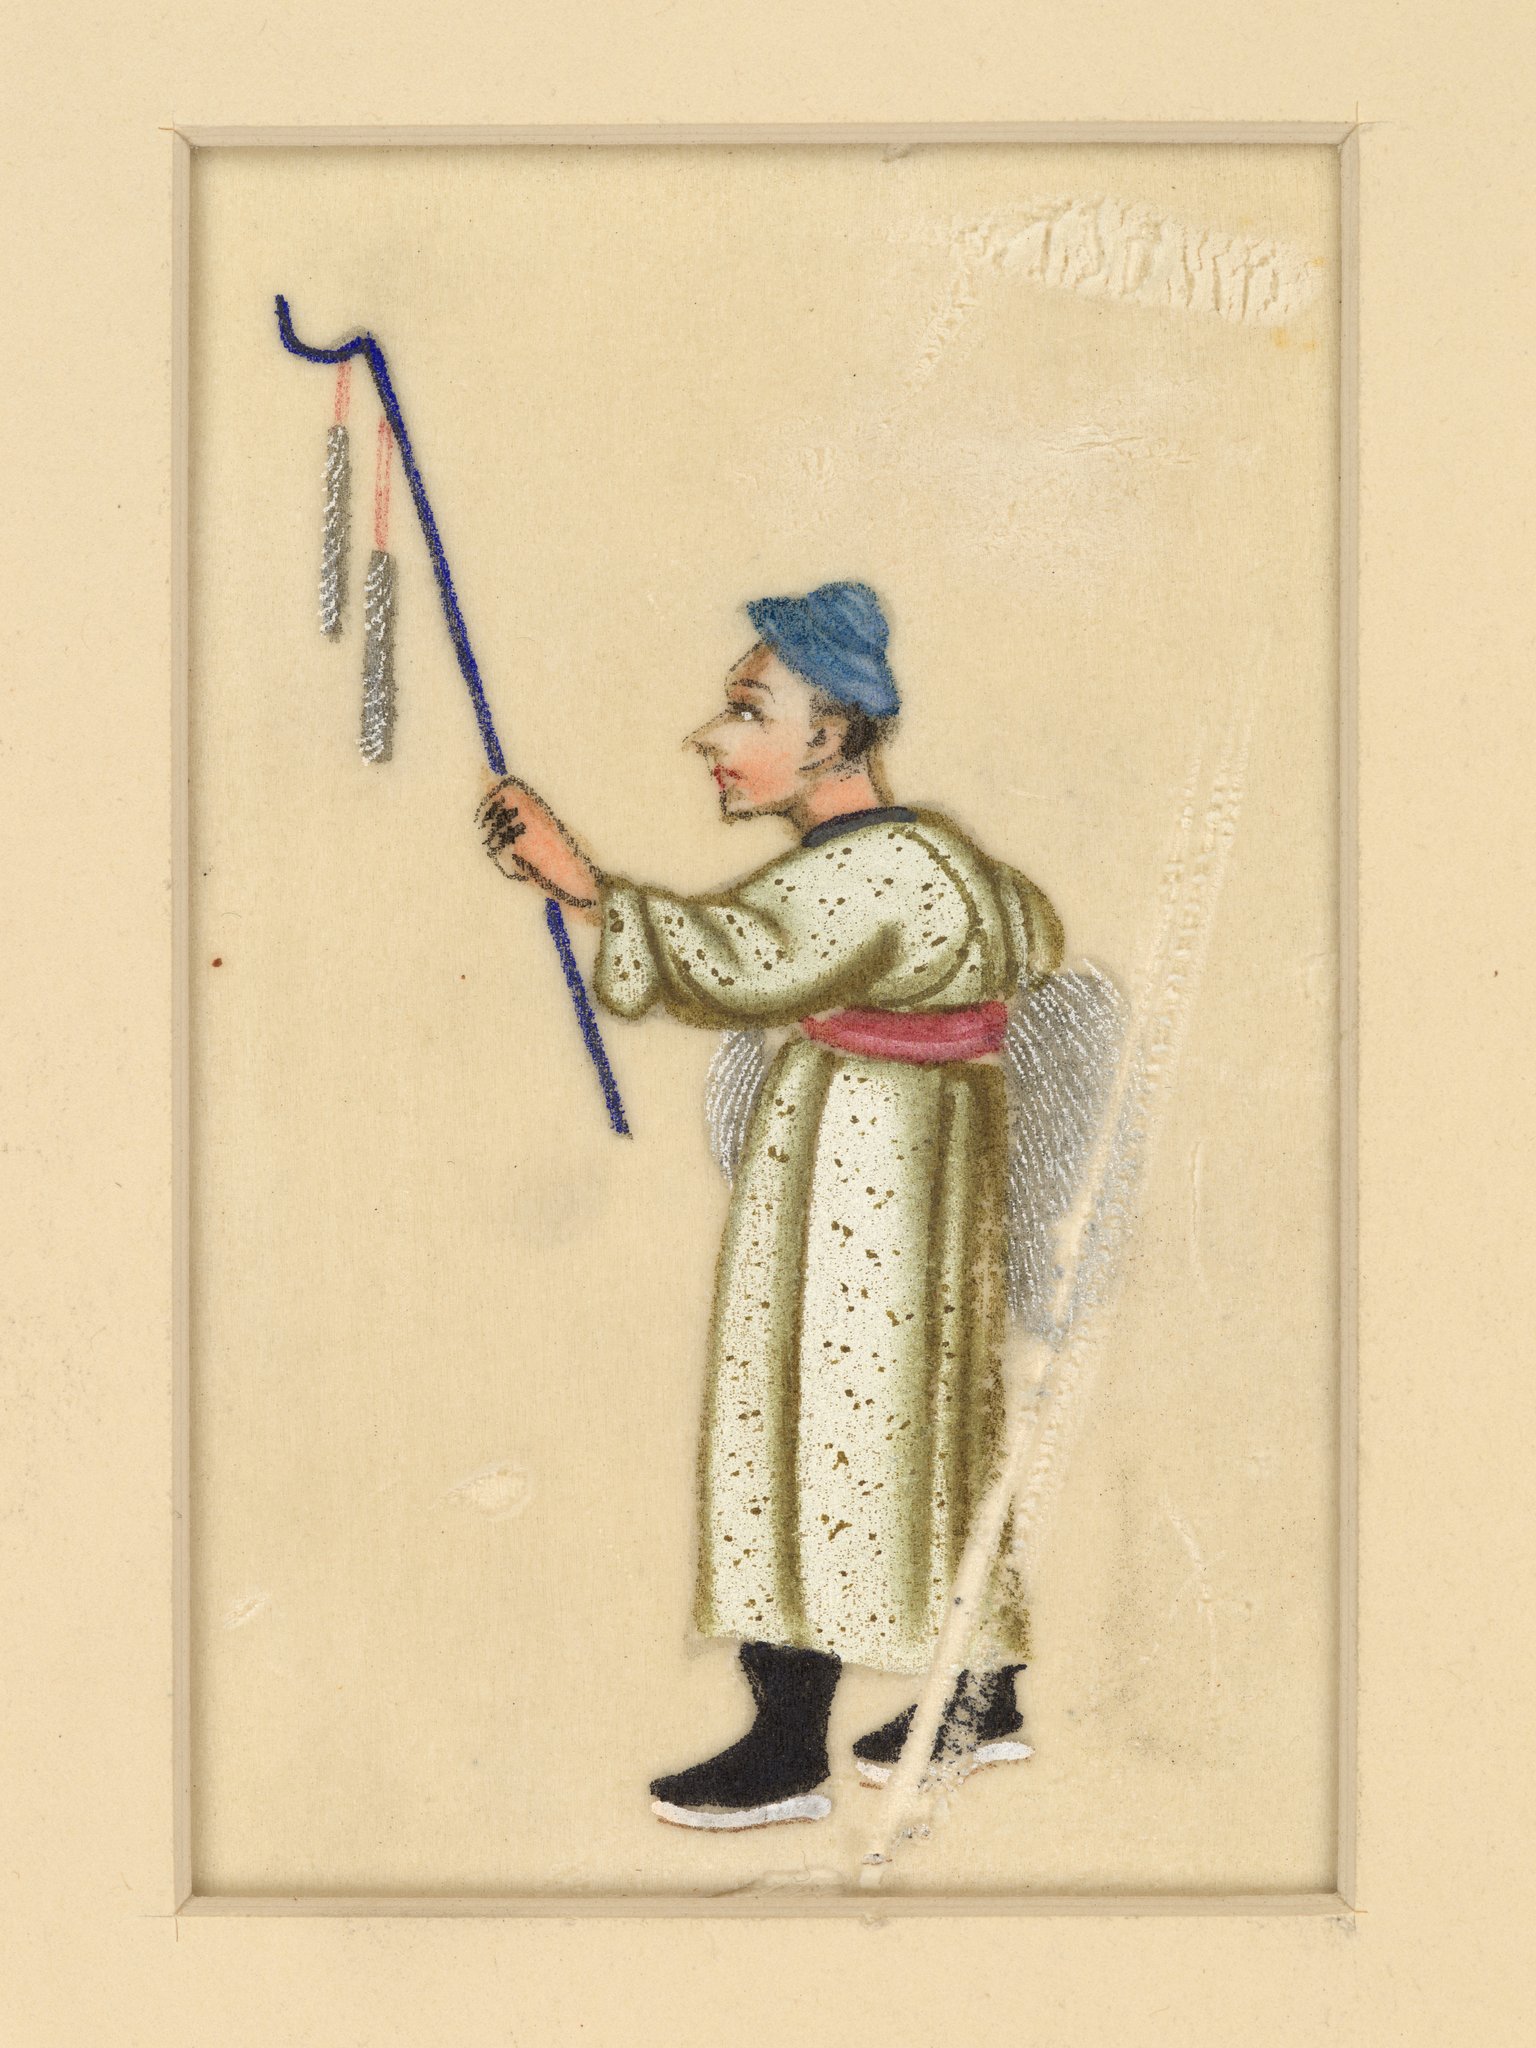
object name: leaf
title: Chicken (or Bird) Vendor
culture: chinese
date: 1901-1933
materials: ink, paper